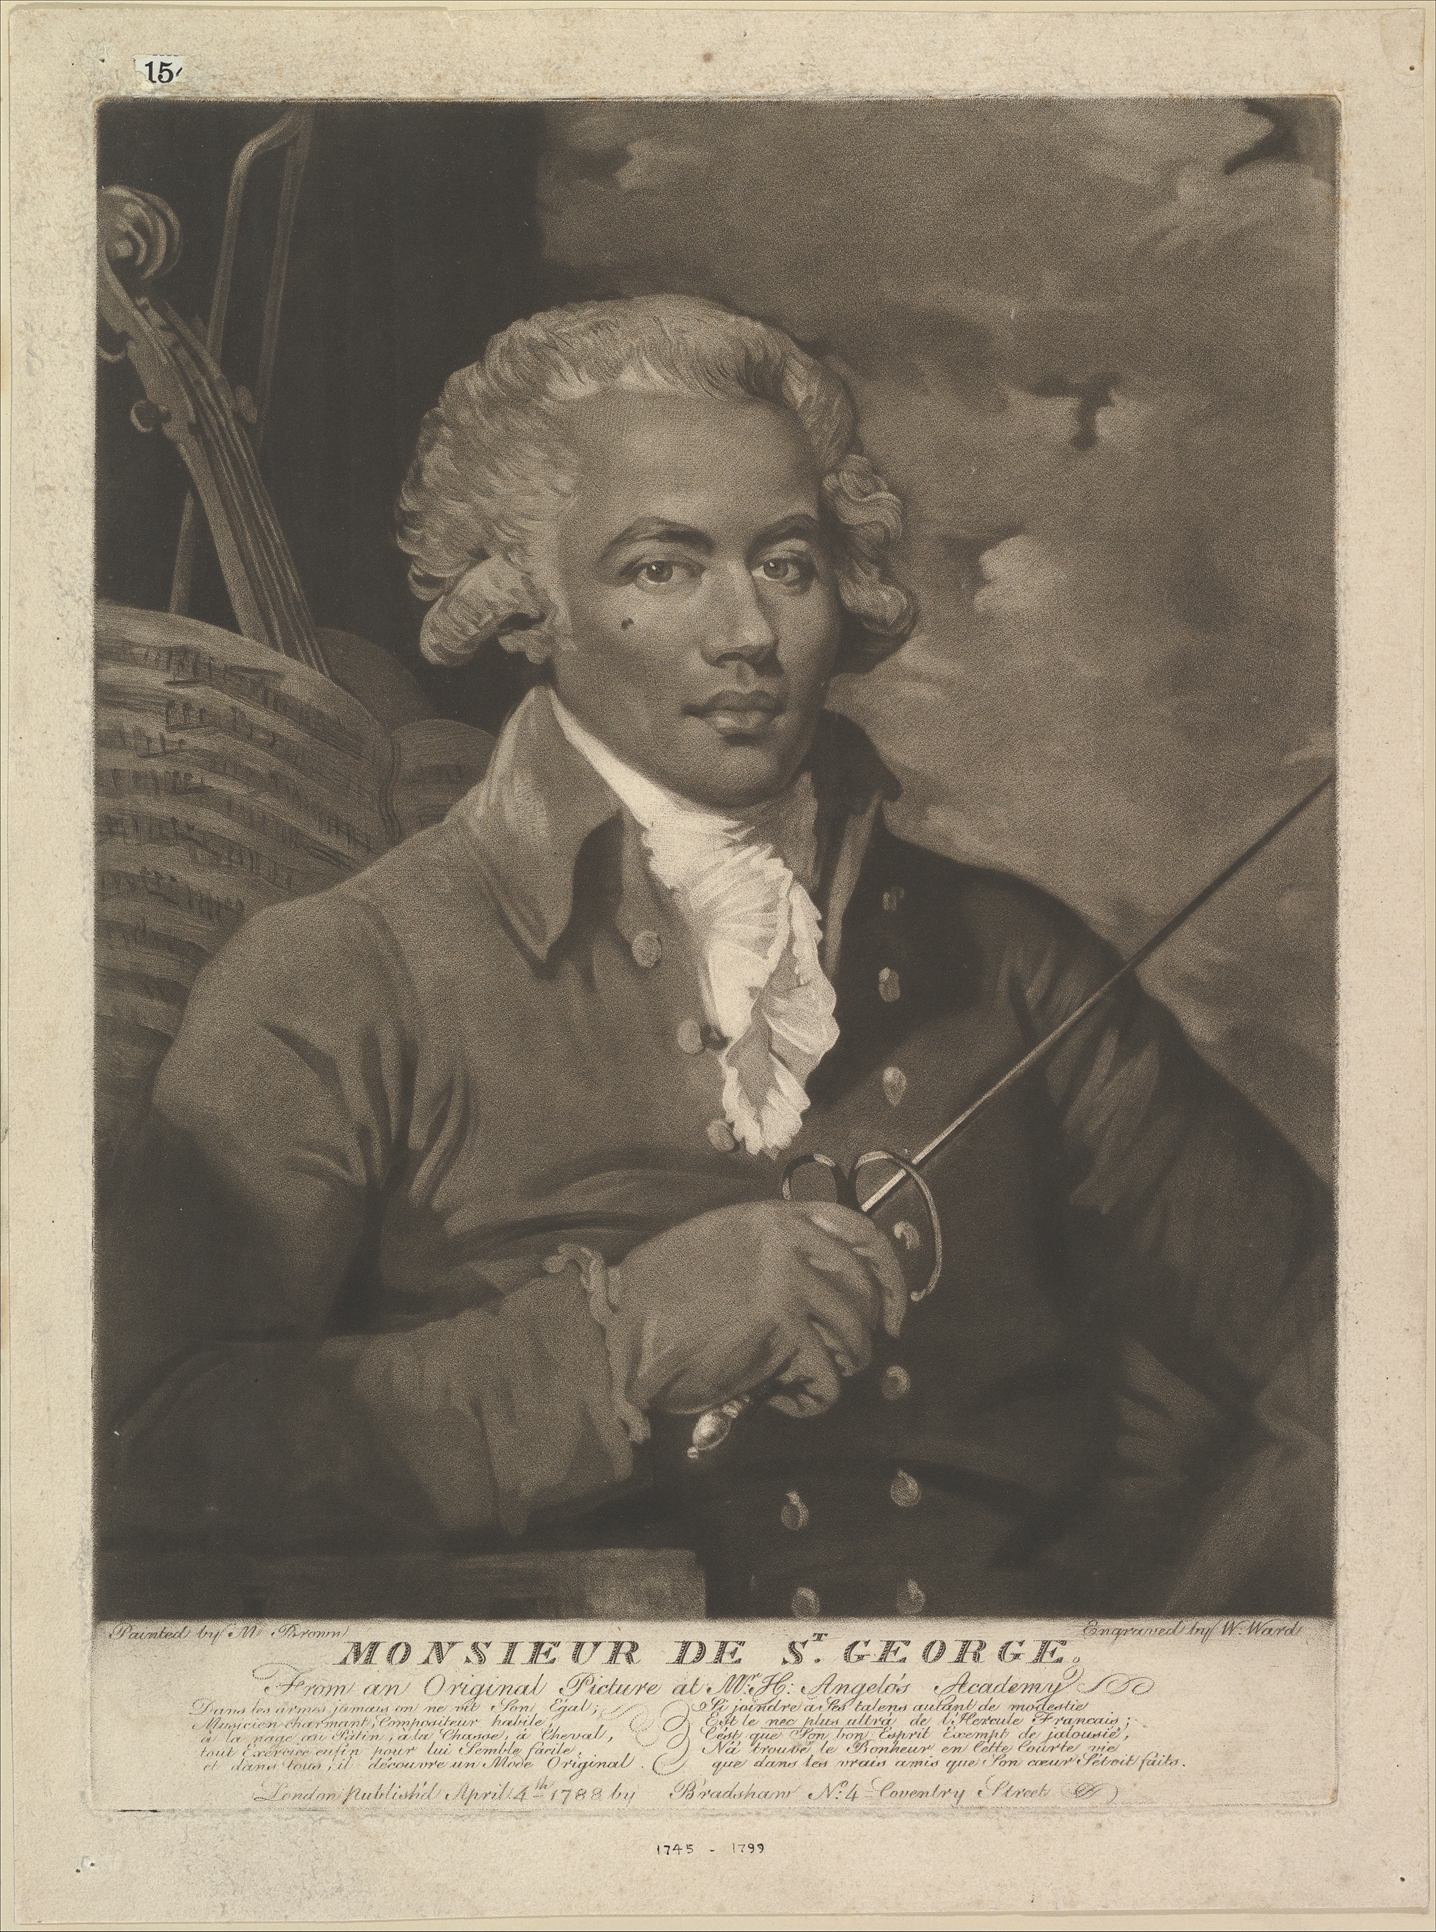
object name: print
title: Monsieur de St. George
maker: william ward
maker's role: engraver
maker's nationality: british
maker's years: 1766-1826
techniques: mezzotint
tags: swords,men,portraits